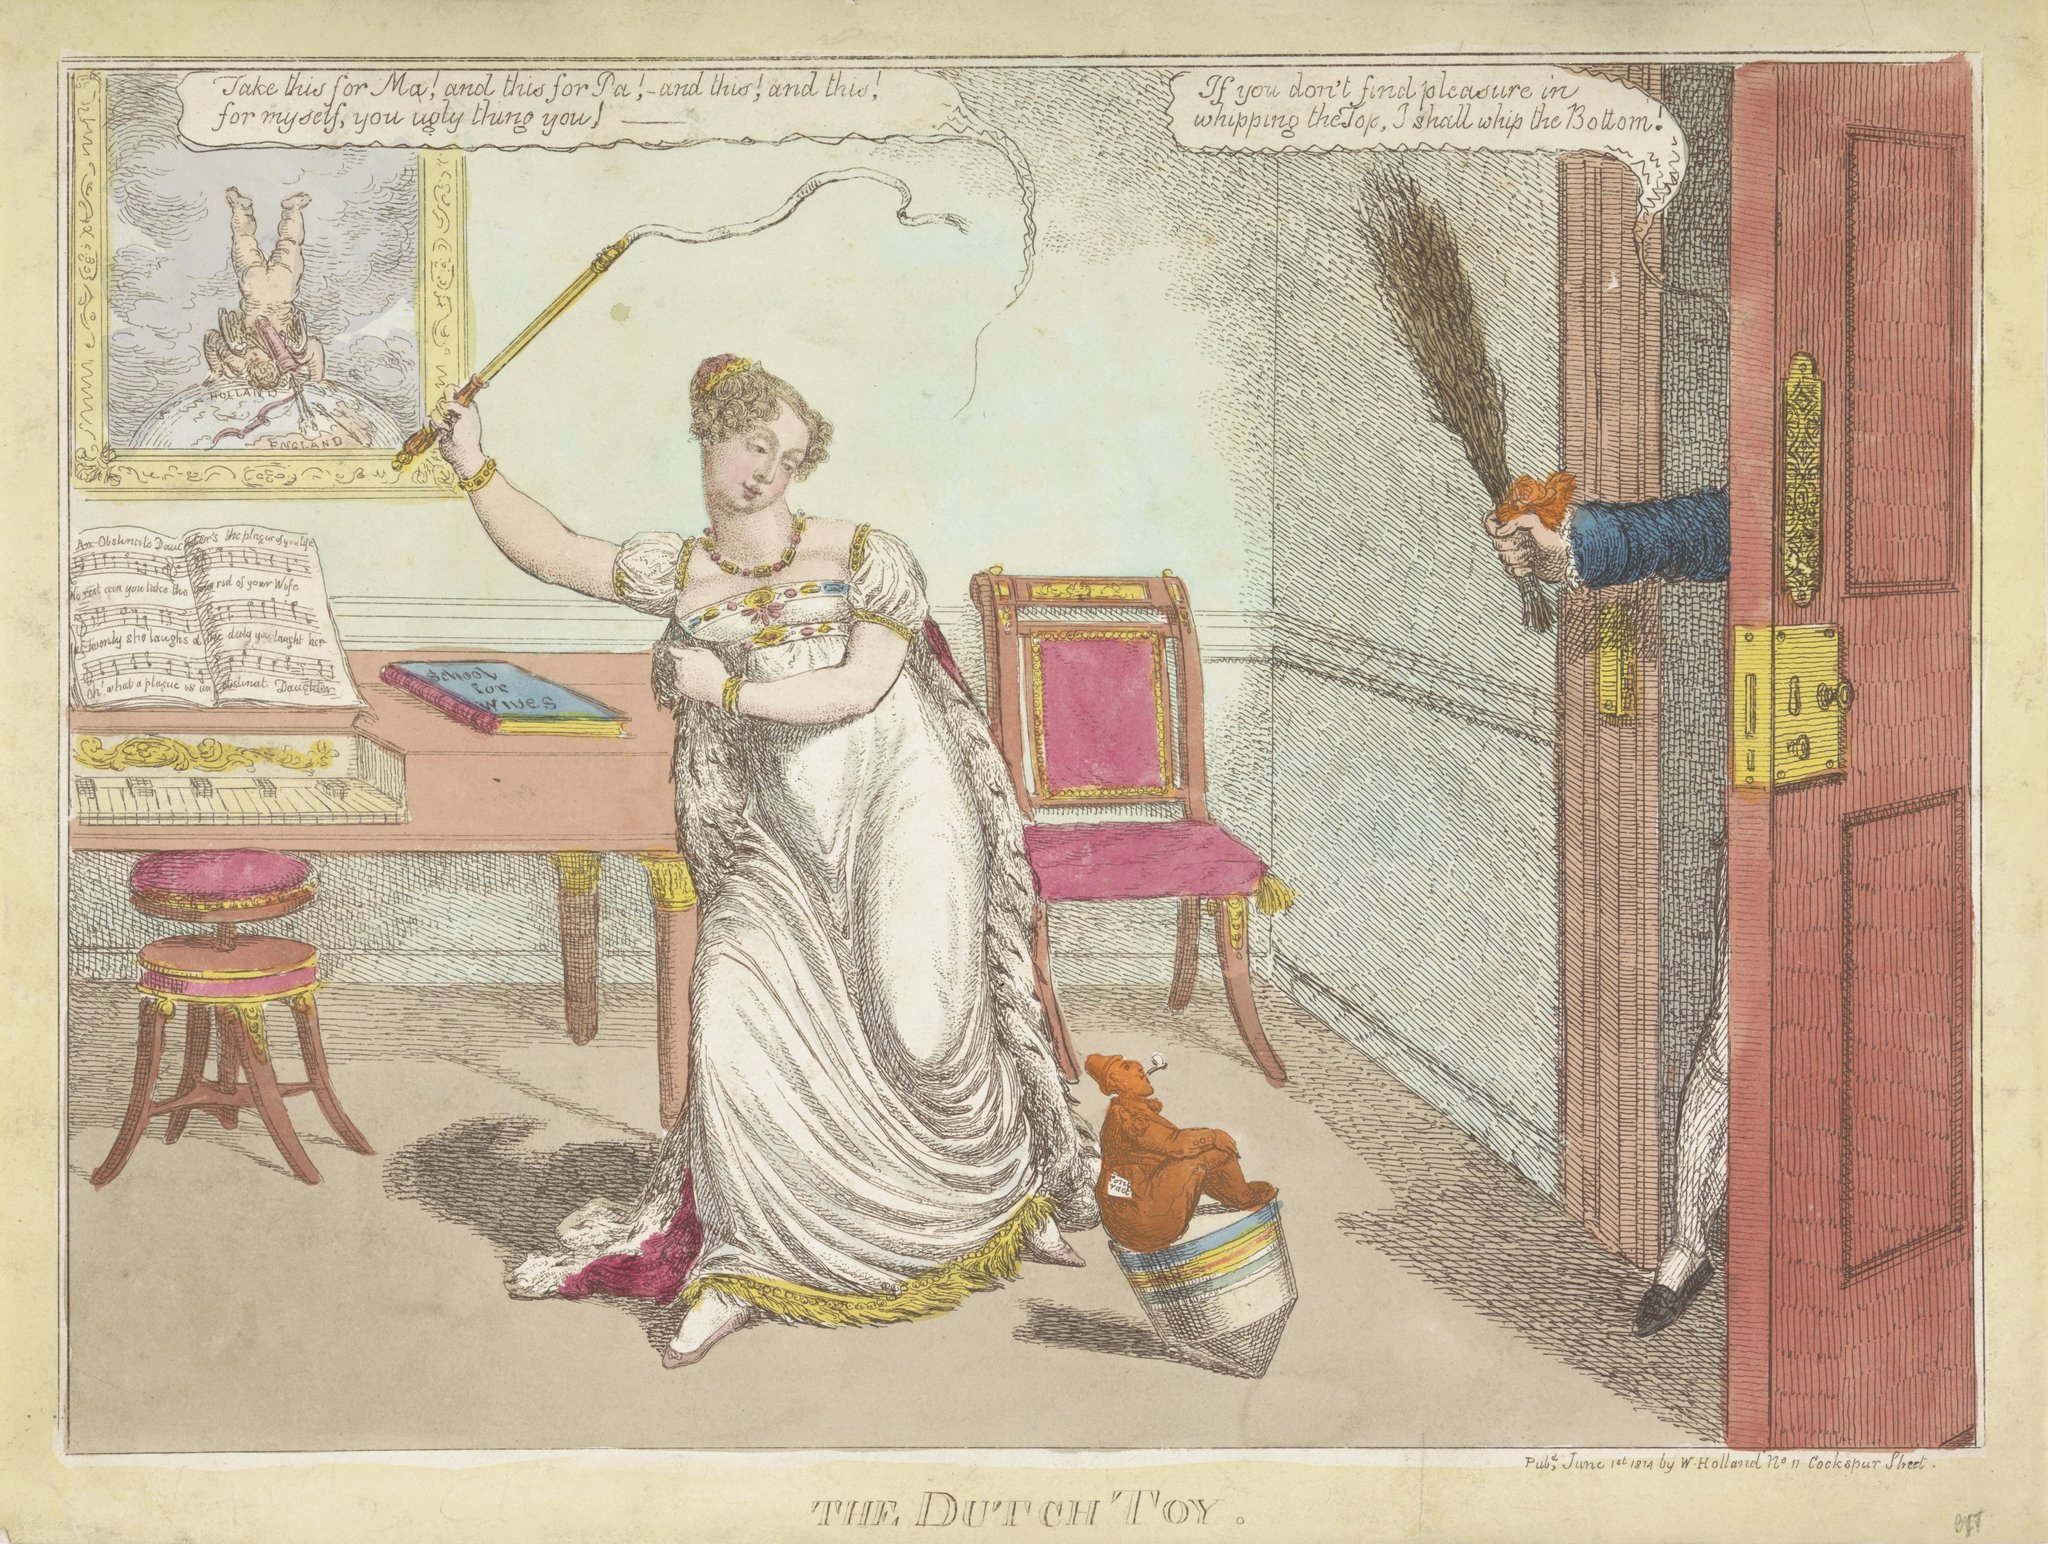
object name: cartoon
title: The Dutch Toy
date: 1814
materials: paper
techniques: etching, hand coloring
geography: england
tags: the hague, william ii of the netherlands, london, charlotte augusta (prinses van wales), whipping a top, unsuccessful love affair; seduction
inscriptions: collector's mark: Lugt 2228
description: Spotprent op Willem Frederik George Lodewijk, prins van Oranje-Nassau (later koning Willem II), voorgesteld als een kleine figuur zittend bovenop een tol door de Engelse prinses Charlotte met een zweep geslagen wordt. Een figuur komend door de deur rechts reikt de prinses een takkenbos aan om mee te slaan. Kamerinterieur met links een piano en daarboven een schilderij van Cupido die op zijn kop staat bovenop de wereldbol. Charlotte zou op 16 juni 1814 haar verloving met de prins van Oranje verbreken.